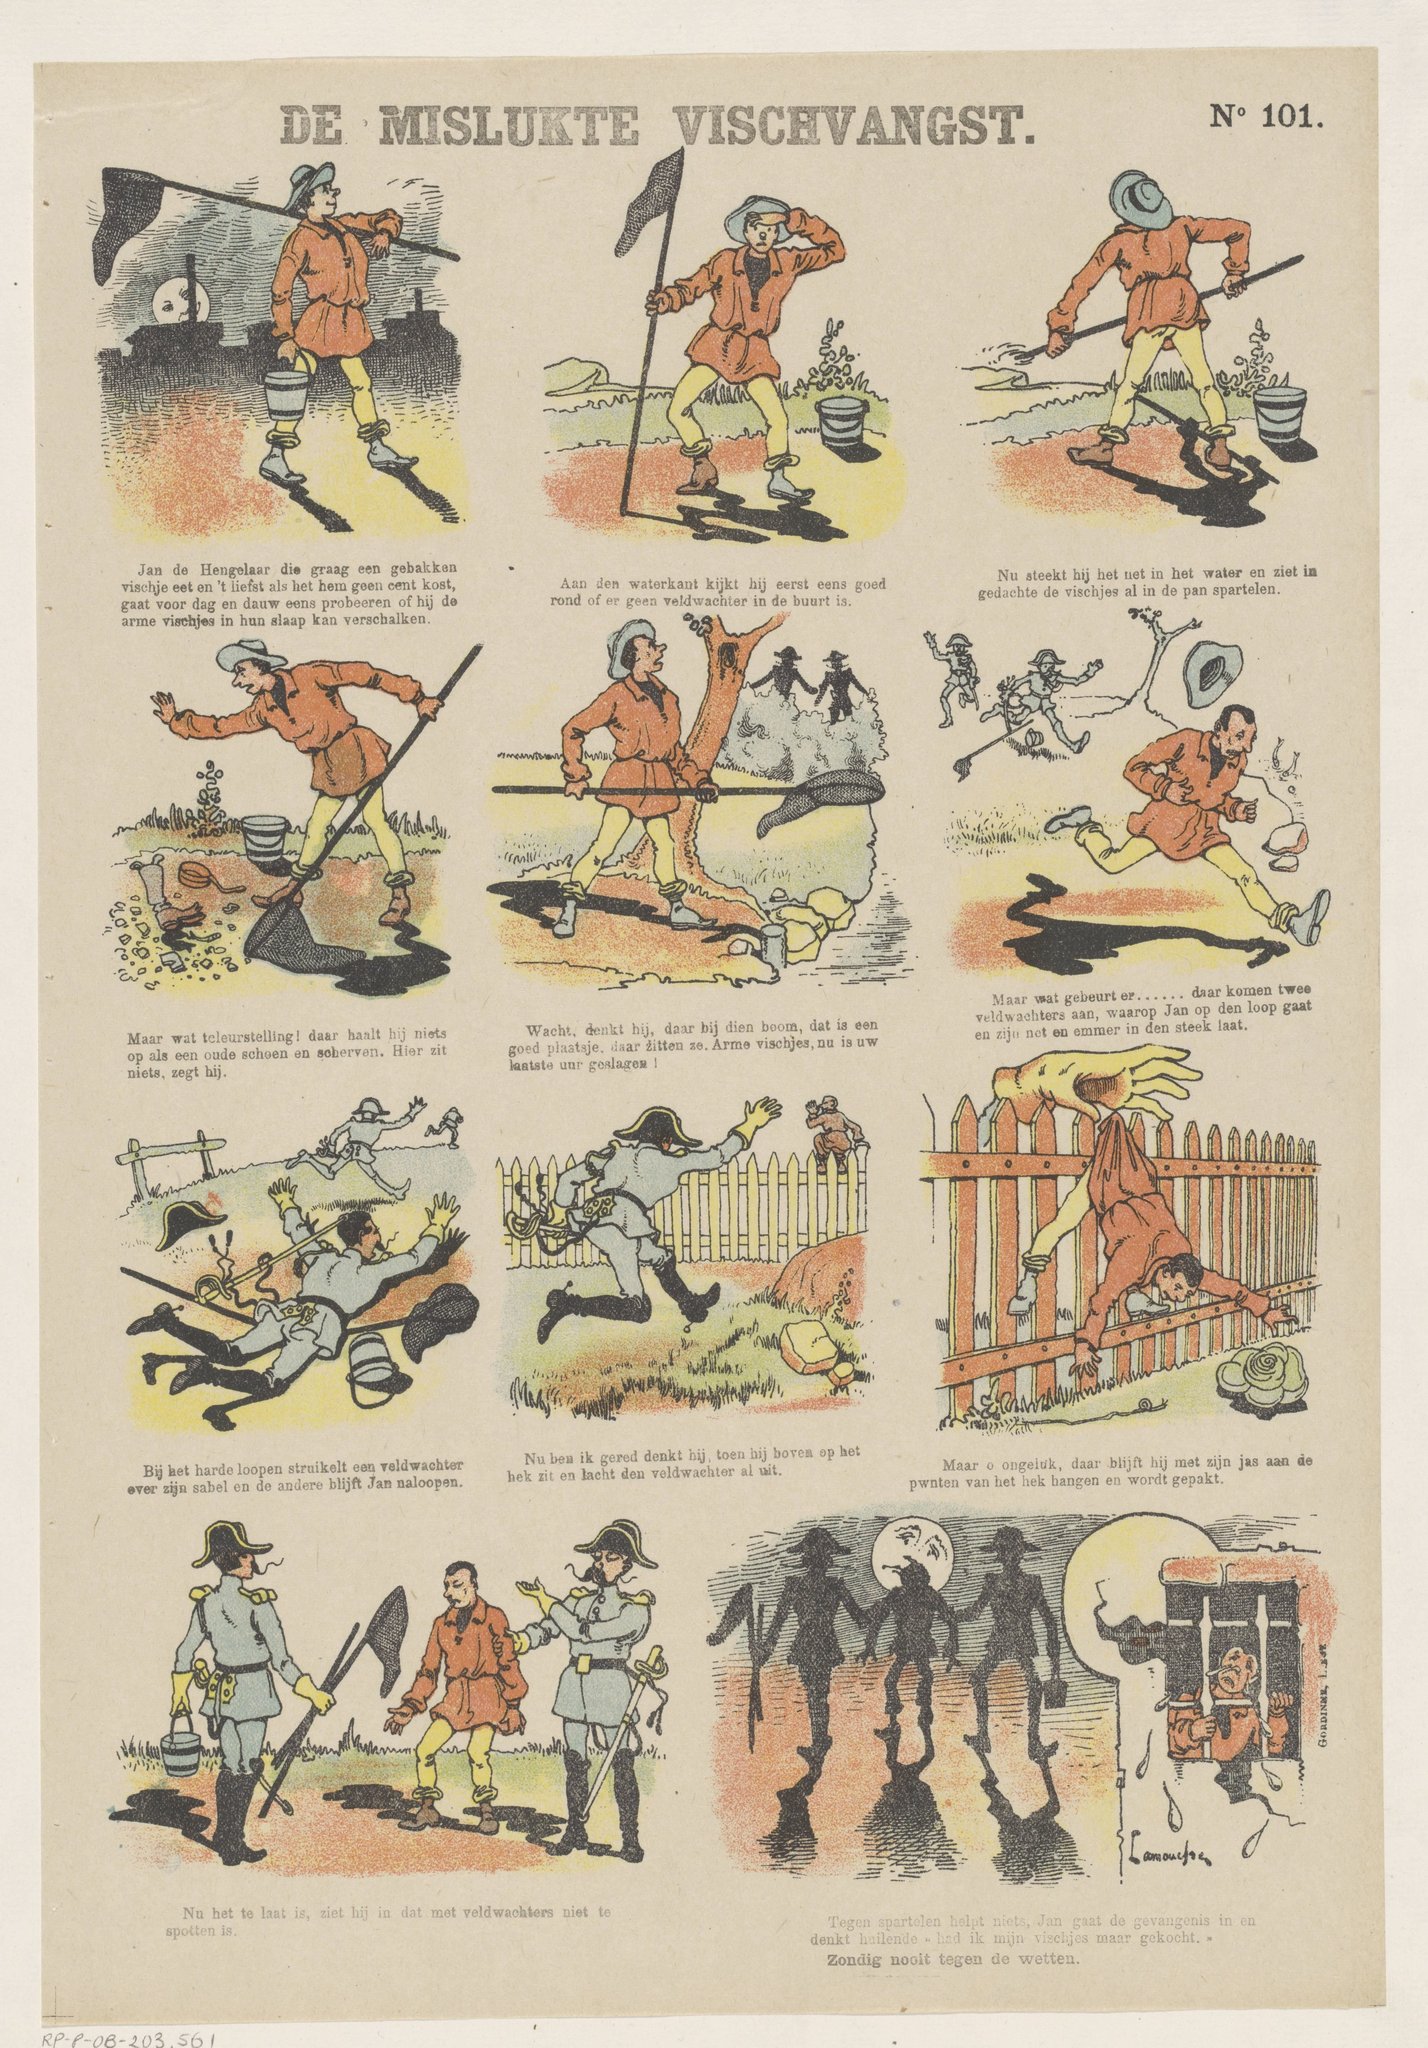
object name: print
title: De mislukte vischvangst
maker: lamouche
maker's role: print maker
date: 1894-1959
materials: paper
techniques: lithograph, letterpress printing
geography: liège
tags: imprisonment, arrest (of criminal), fisherman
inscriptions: collector's mark: Lugt 2760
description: Blad met 12 voorstellingen over Jan de Hengelaar die stiekem gaat vissen en gearresteerd wordt door twee veldwachters. Onder elke afbeelding een onderschrift. Genummerd rechtsboven: No 101.